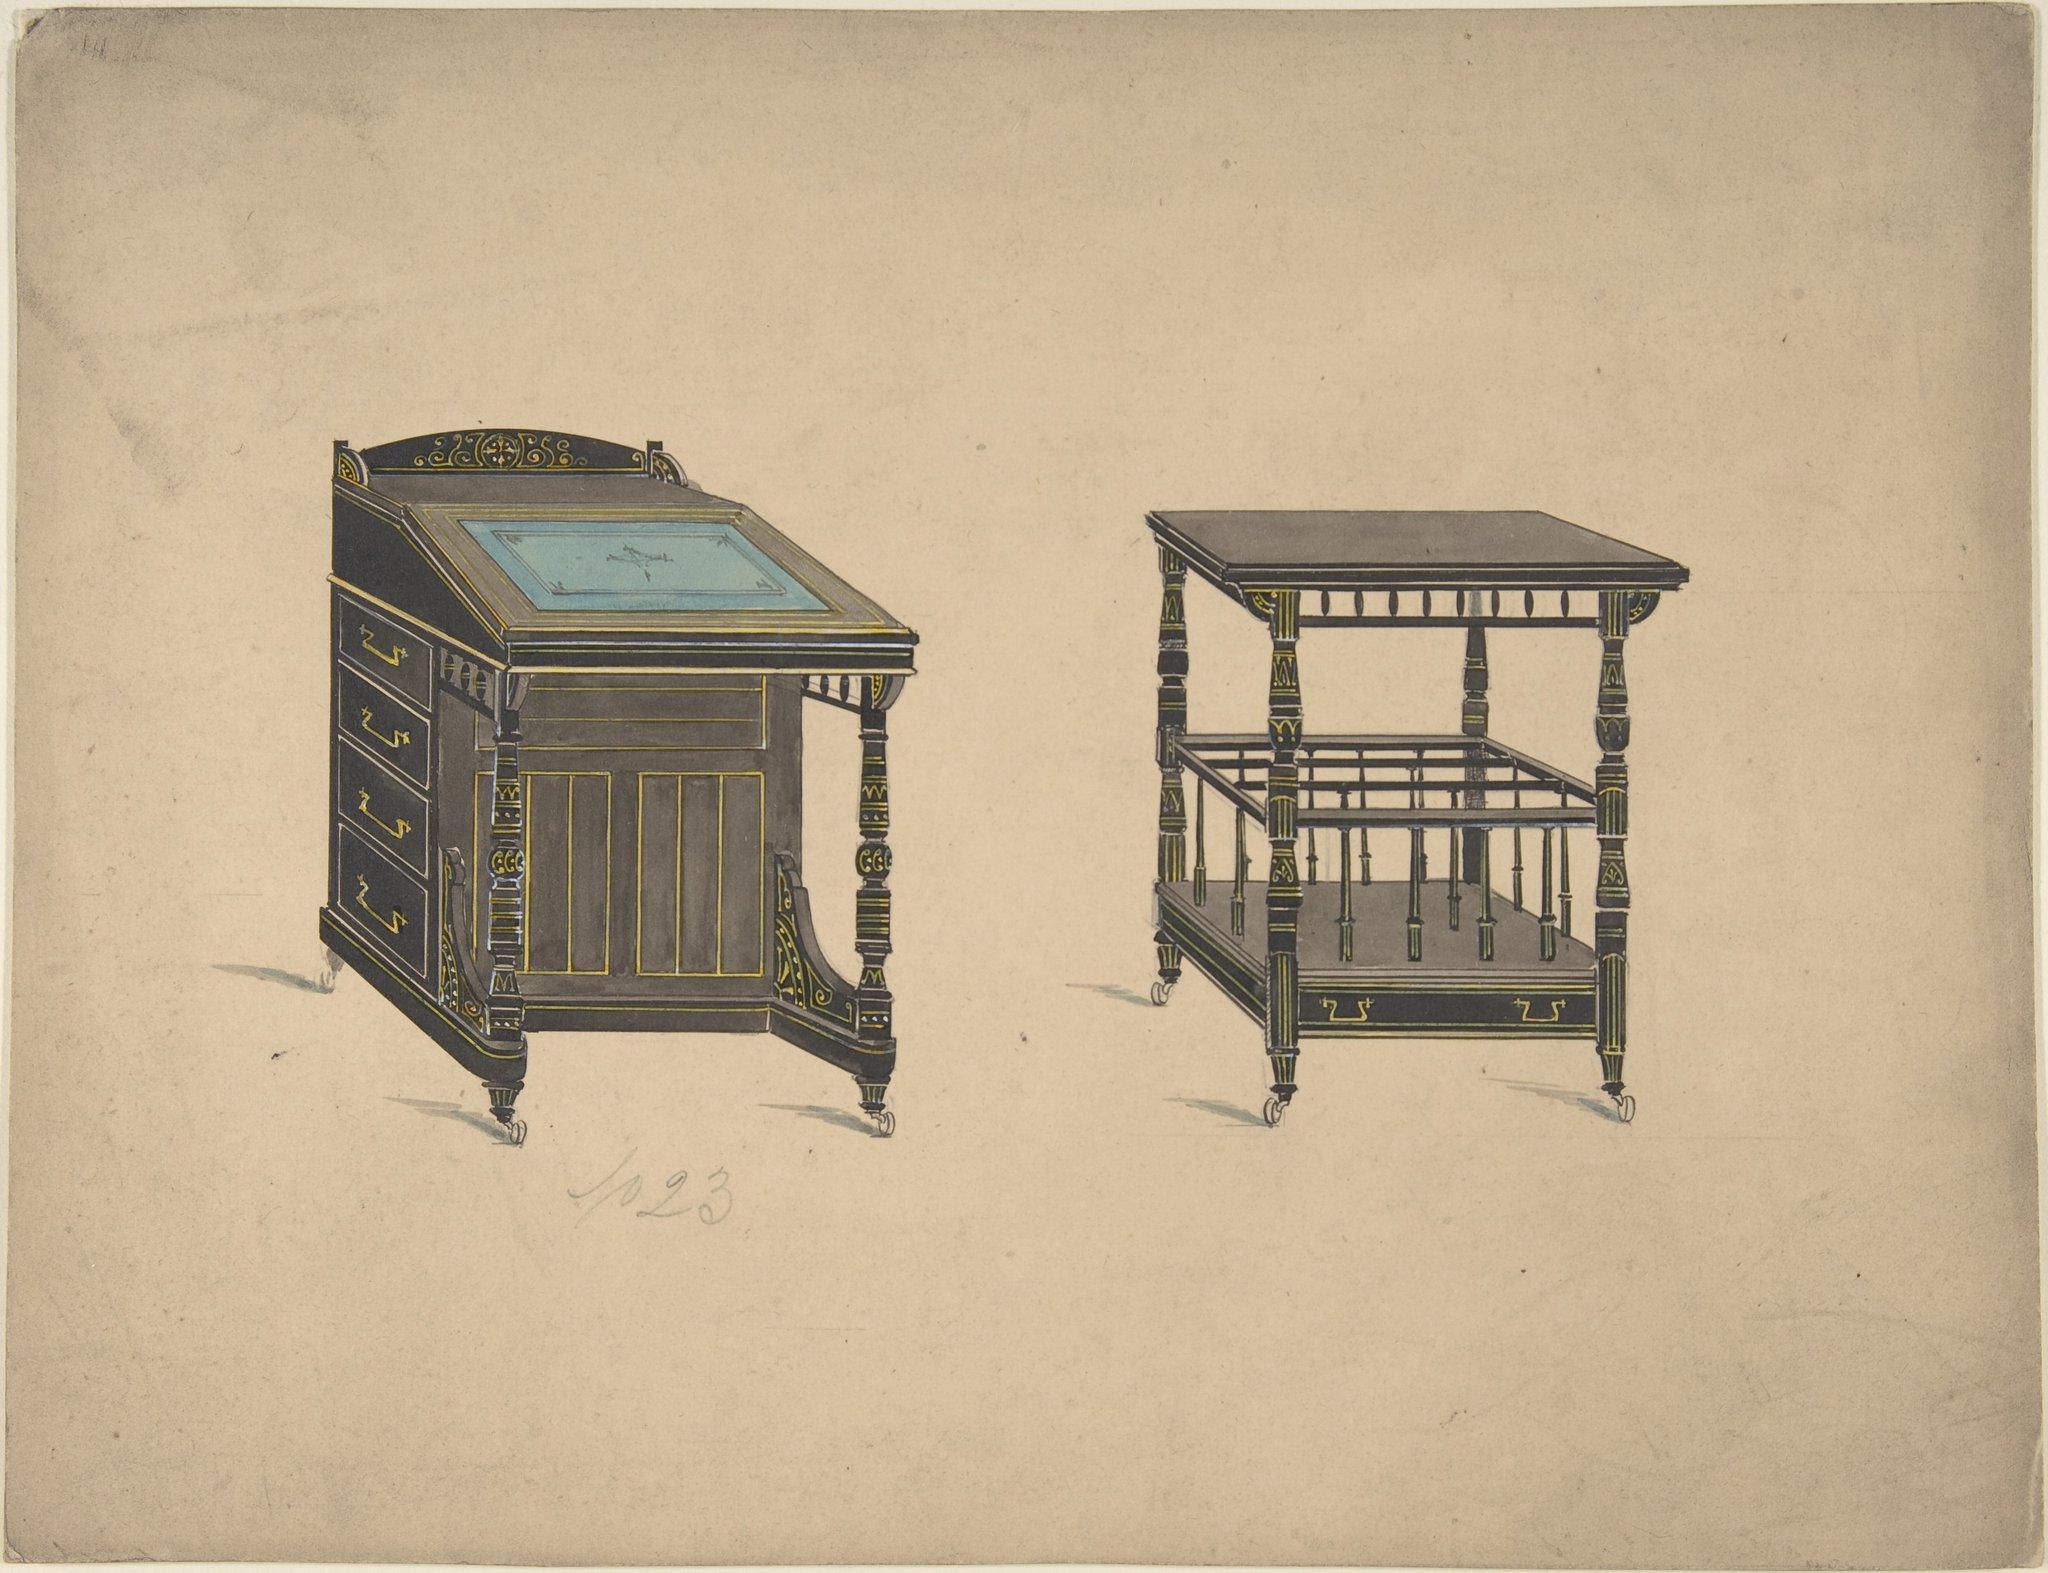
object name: drawing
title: Design for a Desk on Wheels and a Canterbury Table on Wheels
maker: anonymous, british, 19th century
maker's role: artist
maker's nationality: british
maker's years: 1800-1900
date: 1801-1900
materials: gouache, ink, watercolor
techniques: pen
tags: desks,tables